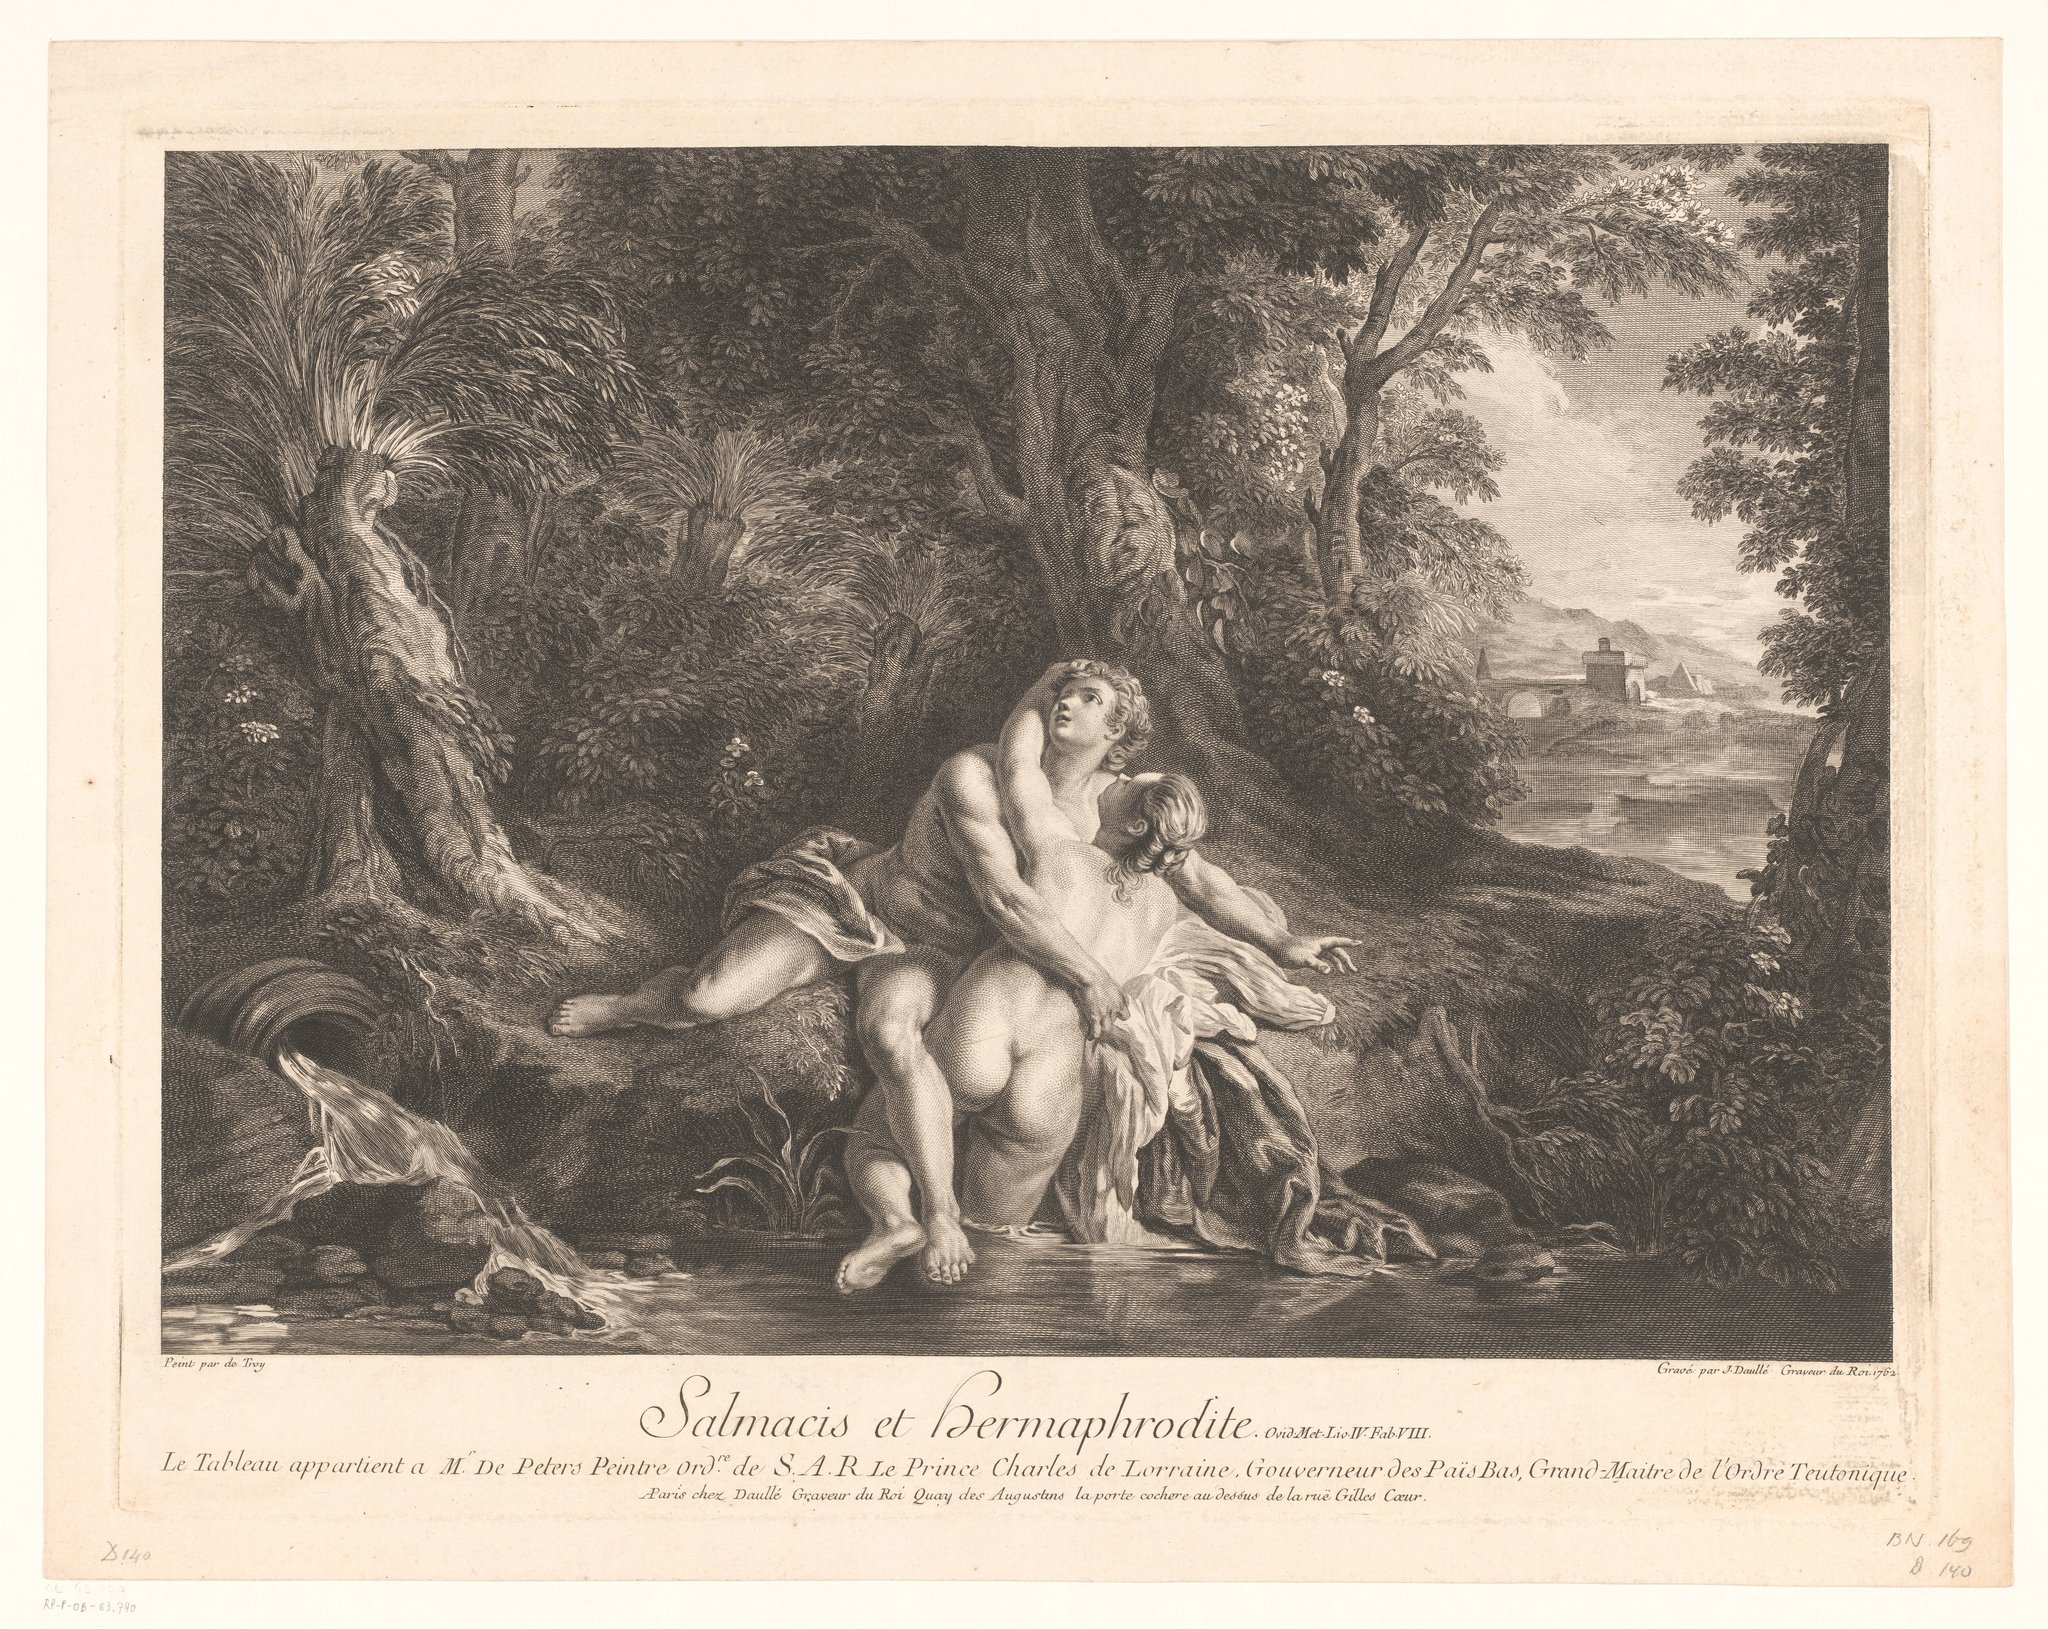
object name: print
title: Salmacis et Hermaphrodite.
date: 1762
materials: paper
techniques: engraving, etching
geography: paris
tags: story of hermaphroditus and salmacis, landscapes, hermaphroditus and salmacis changed into a hermaphrodite: at the prayer of the fountain-nymph salmacis, who holds the bathing hermaphroditus closely embraced, their bodies fuse (ovid, metamorphoses iv 373)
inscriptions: collector's mark: Lugt 2228